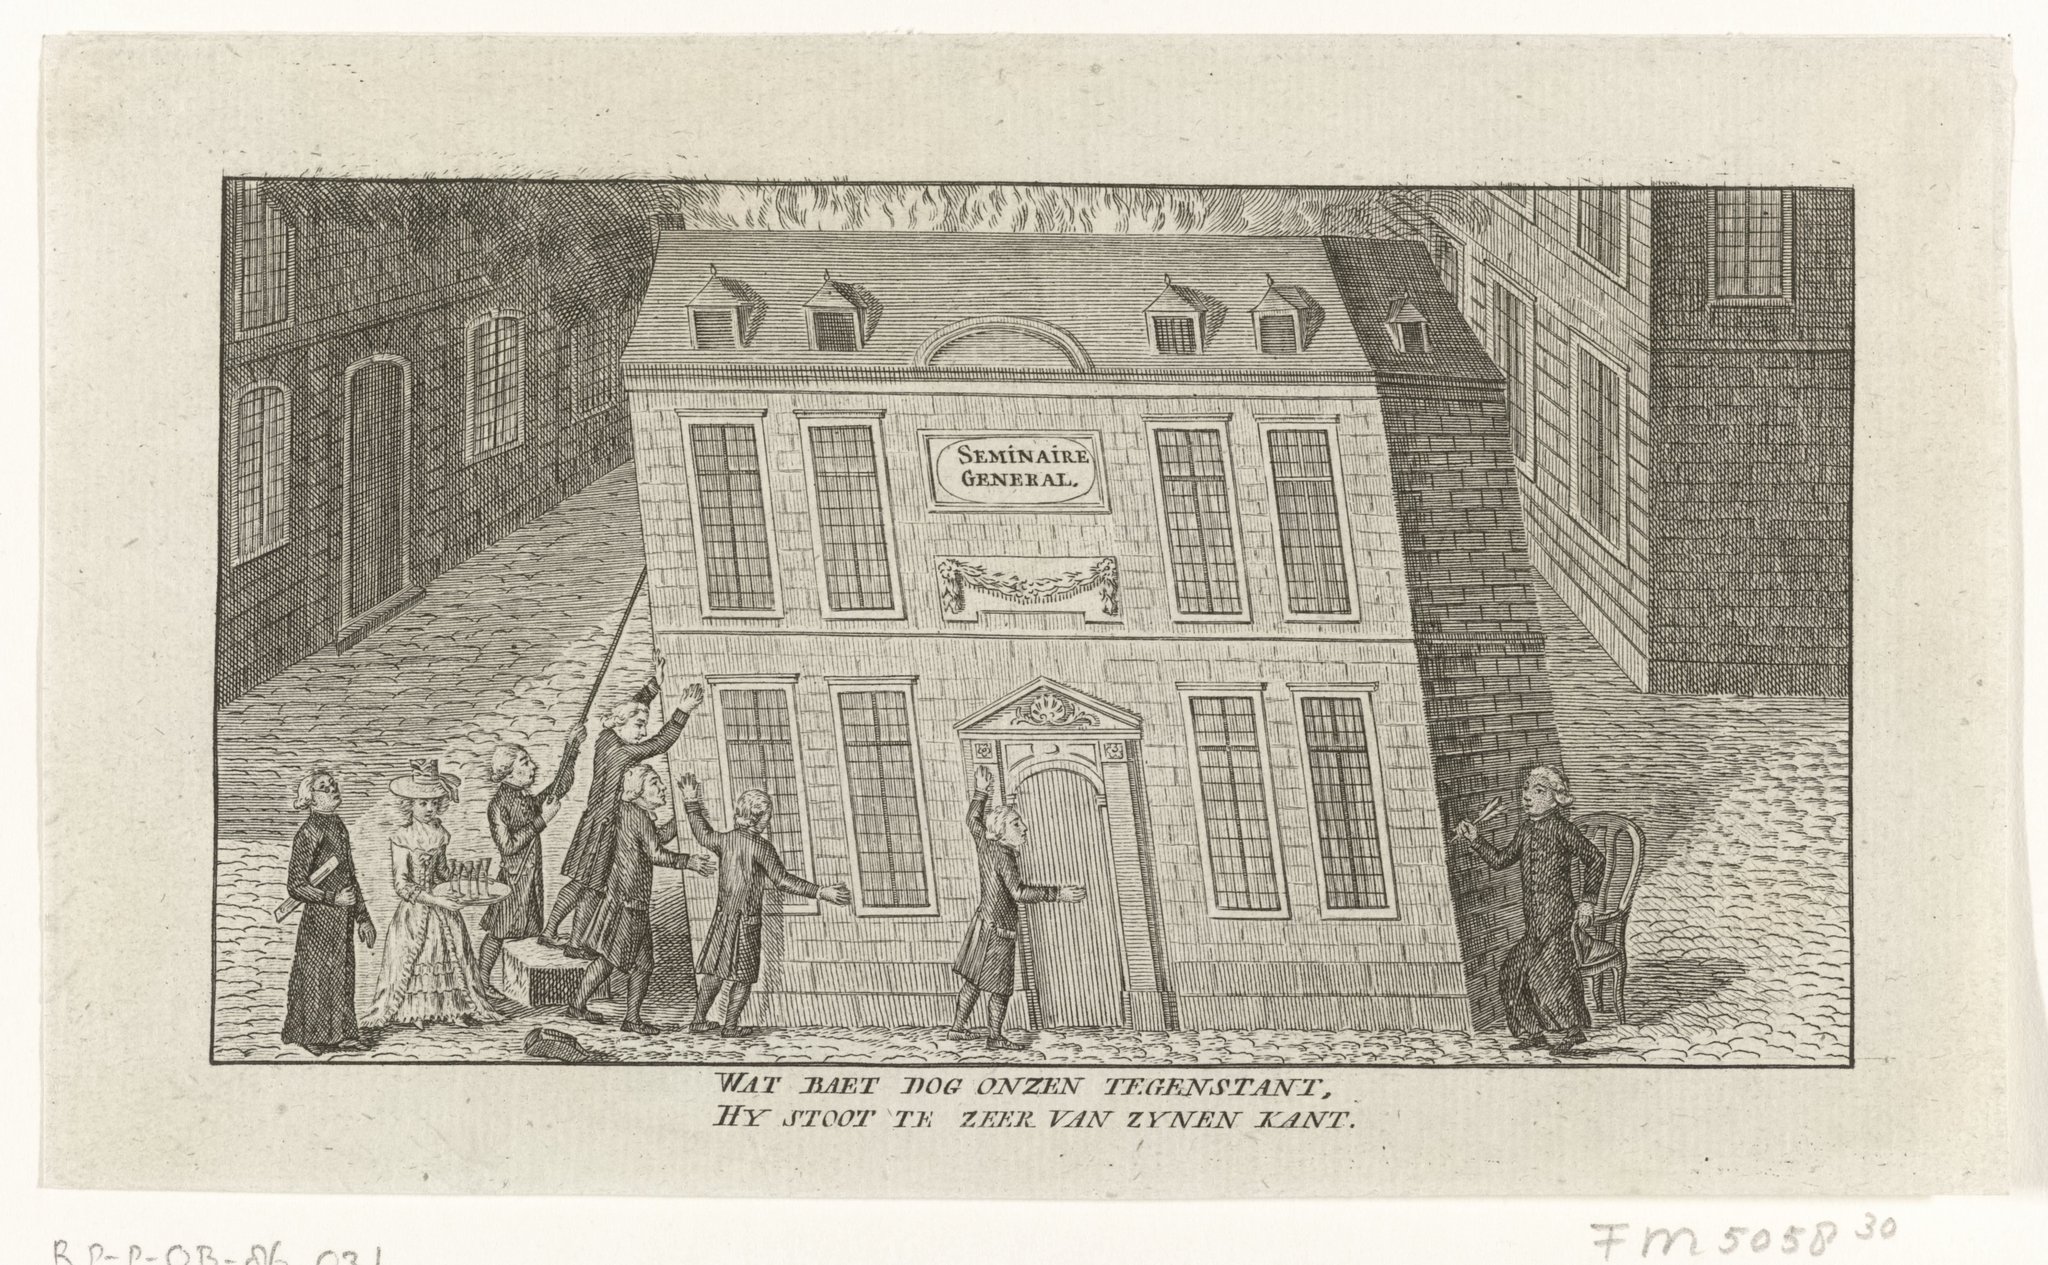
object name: cartoon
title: Brabantse Omwenteling, 1787-1790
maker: Anonymous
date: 1787-1790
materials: paper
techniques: engraving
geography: southern netherlands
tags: collapsing building, brabant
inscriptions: collector's mark: Lugt 2228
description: Spotprent op de opheffing van de seminaria door keizer Jozef II. Een scheef staande seminariegebouw staat in brand, pogingen van de groep personen links om het overeind te houden baten niet. Met tweeregelig vers in het Nederlands. Onderdeel van een grote groep van prenten betrekking hebbend op de gebeurtenissen van de Brabantse Omwenteling en de periode 1787-1790.